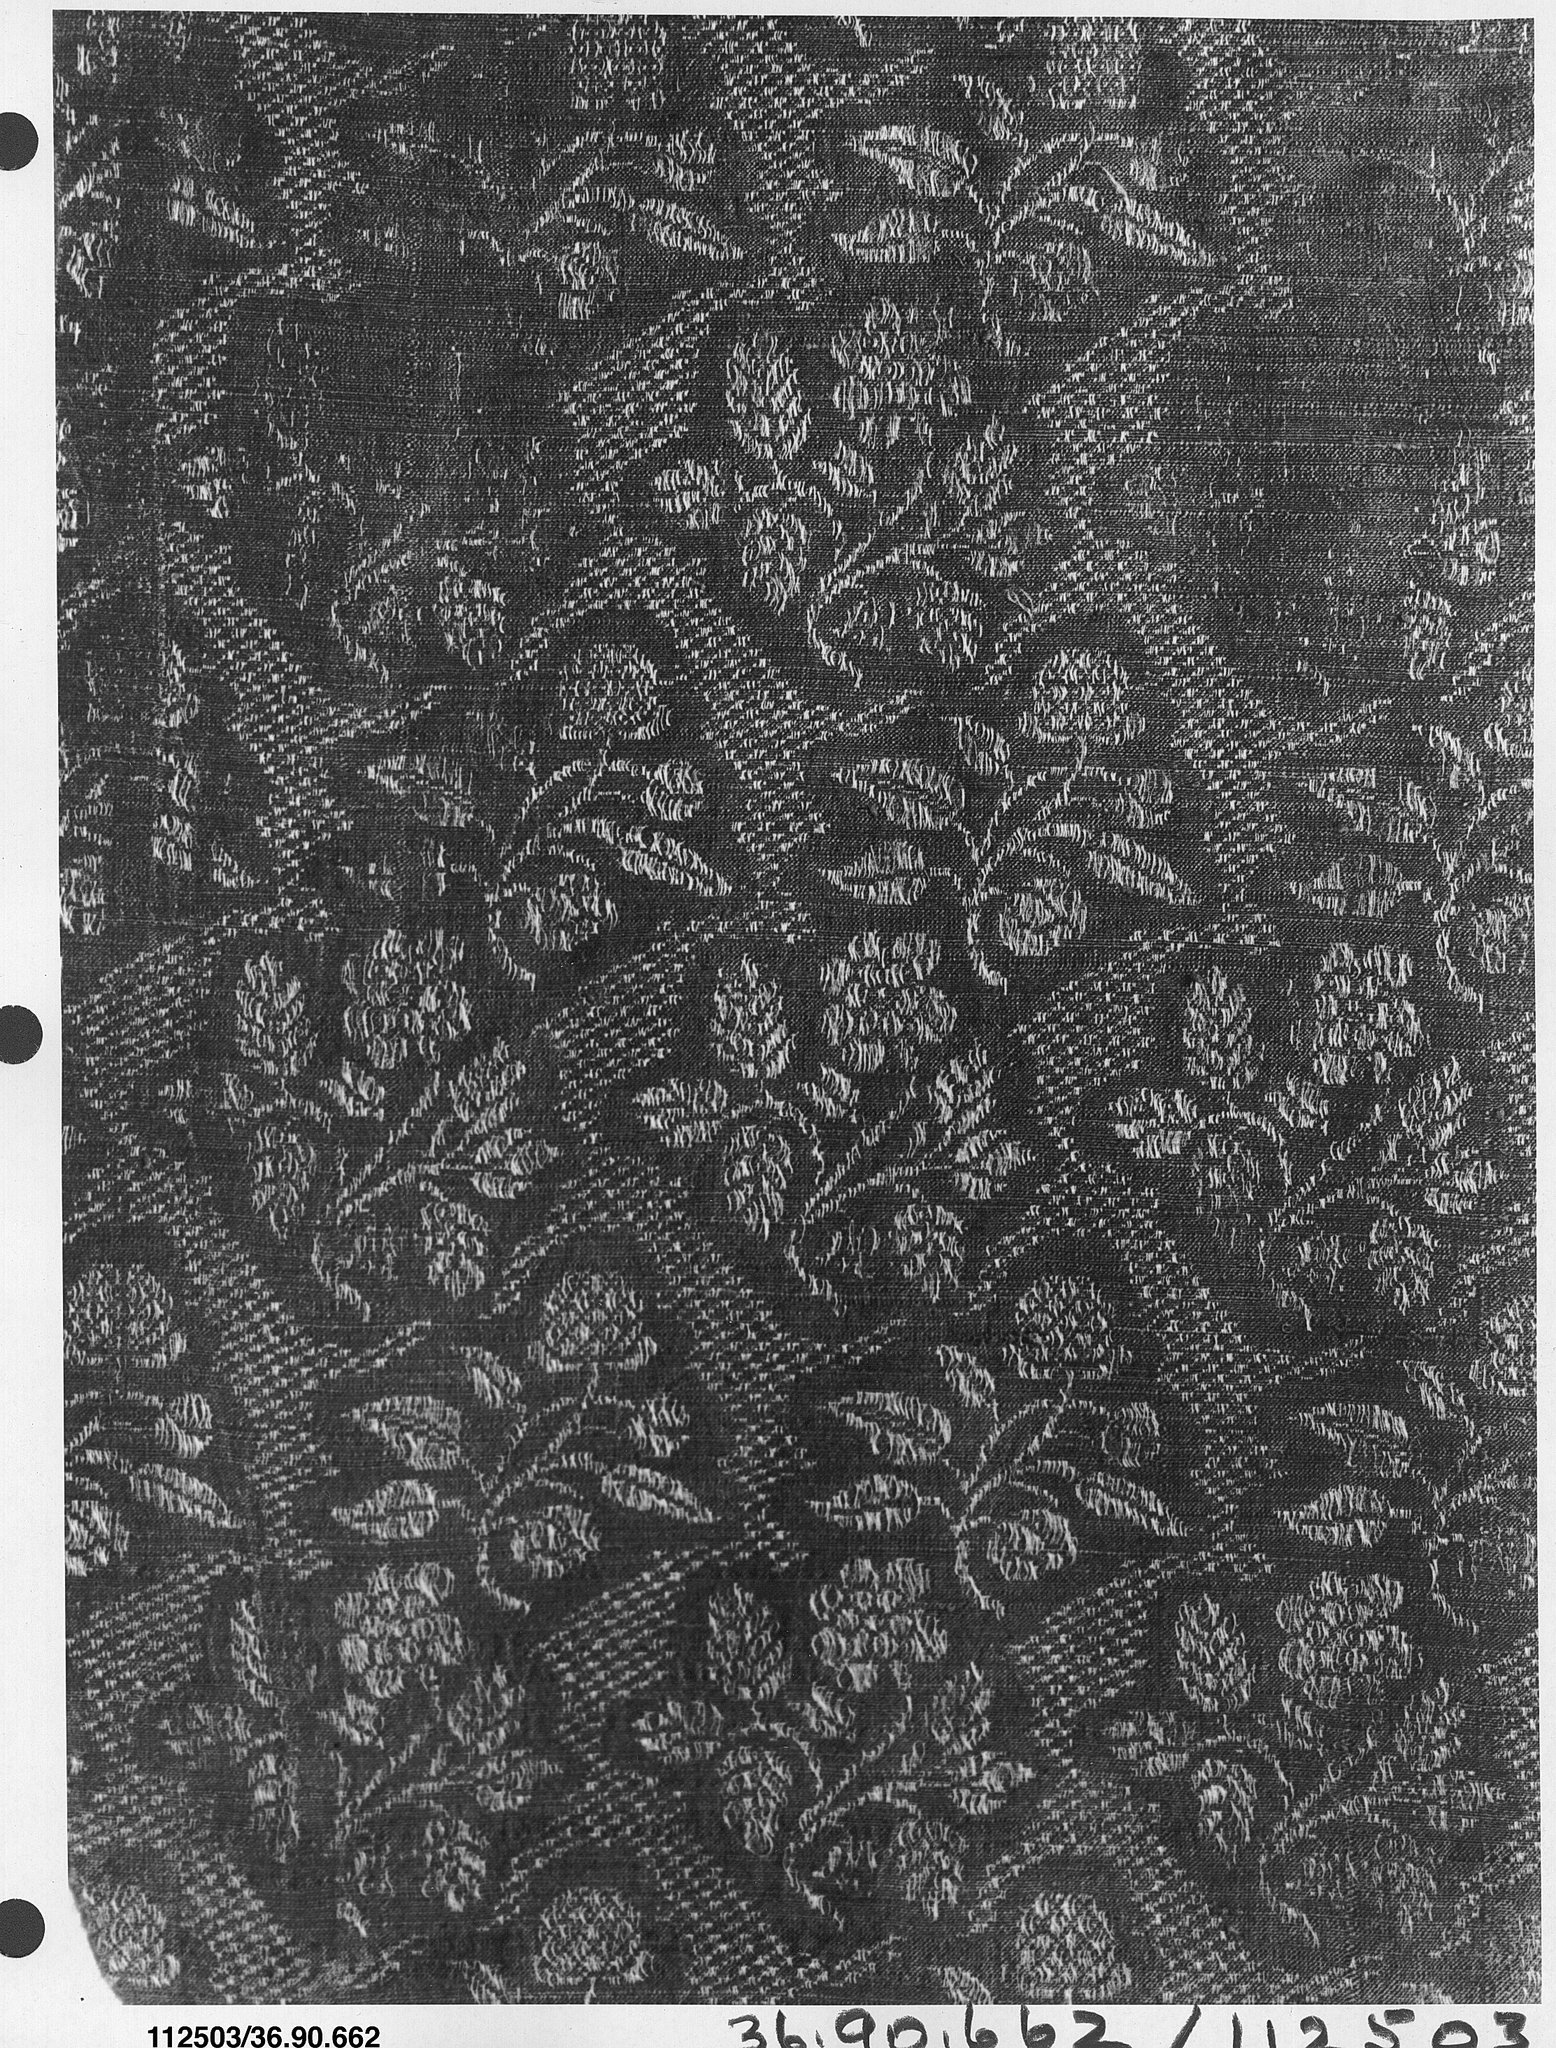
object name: piece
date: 1701-1800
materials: silk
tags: flowers,leaves